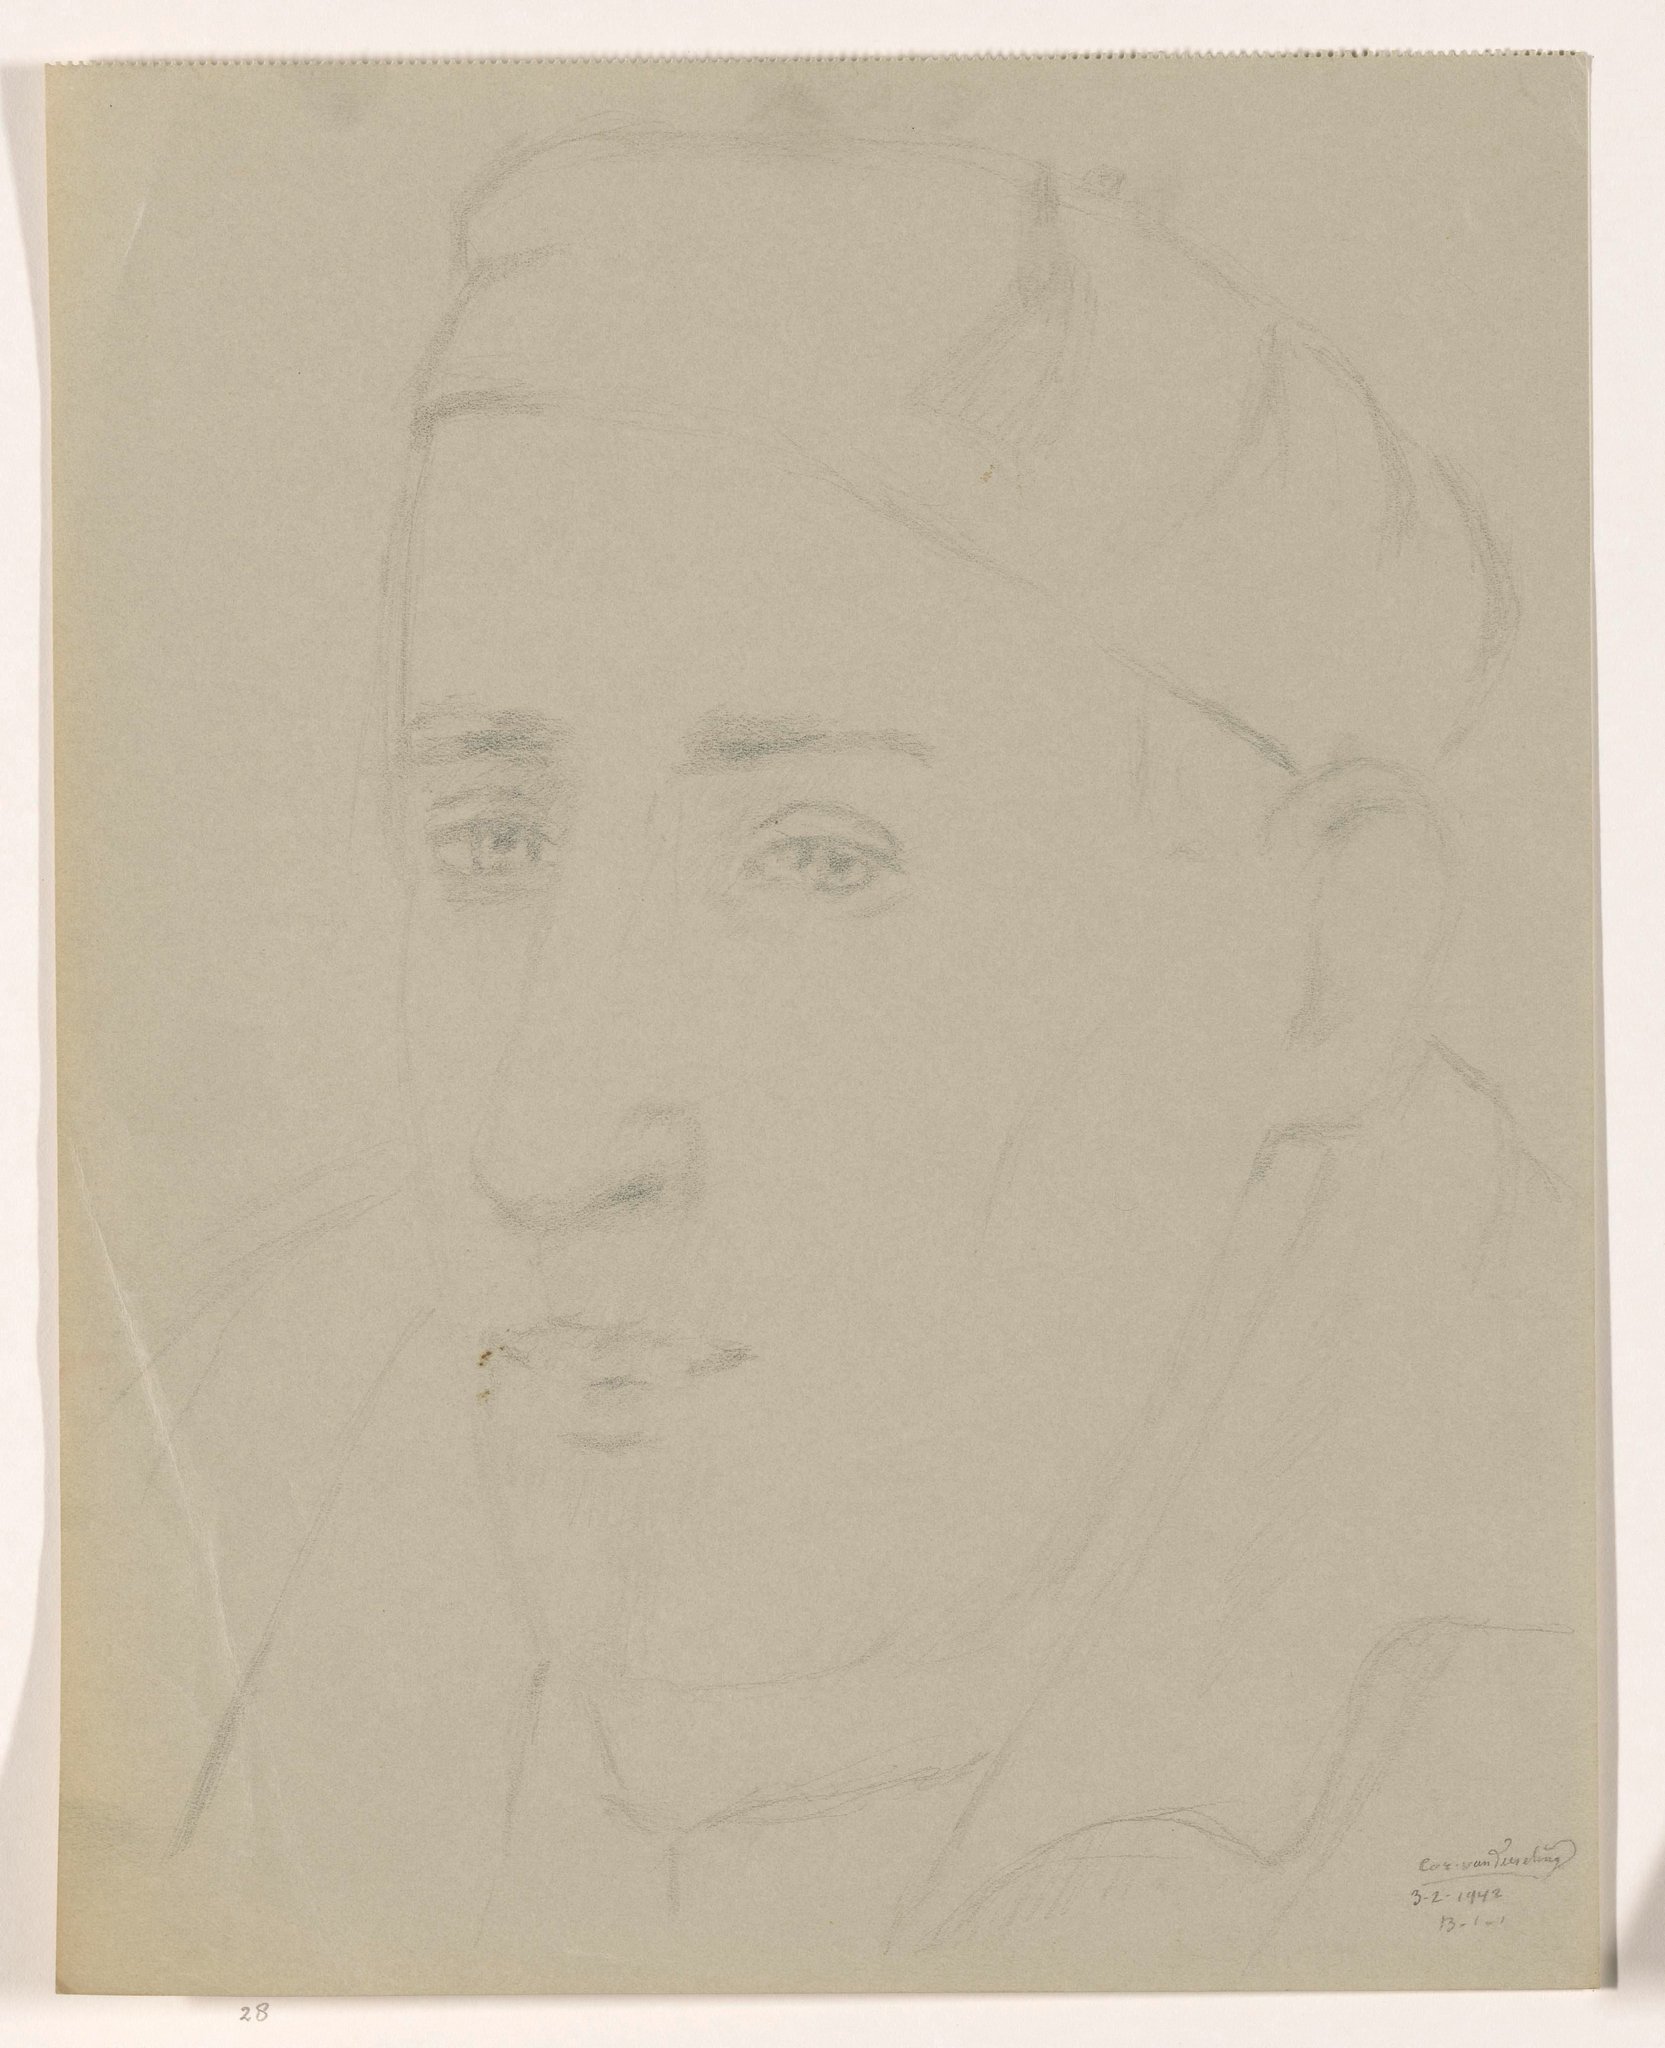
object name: drawing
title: Zelfportret: B-1-1, 3 februari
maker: cor van teeseling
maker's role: draughtsman, sculptor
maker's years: 1915-1942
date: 1942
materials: paper, pencil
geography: weteringschans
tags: amsterdam, cor van teeseling, historical persons, prisoner in cell or locked place, portrait, self-portrait of draughtsman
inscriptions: signature and date: ‘3-2-1942 / Cor van Teeseling / B-1-1’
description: Zelfportret van Cor van Teeseling: in de gevangenis aan de Weteringschans, cel B-1-1, 3 februari. Getekend zelfportret van Cor van Teeseling driekwart met zijn hoofd naar links gewend.